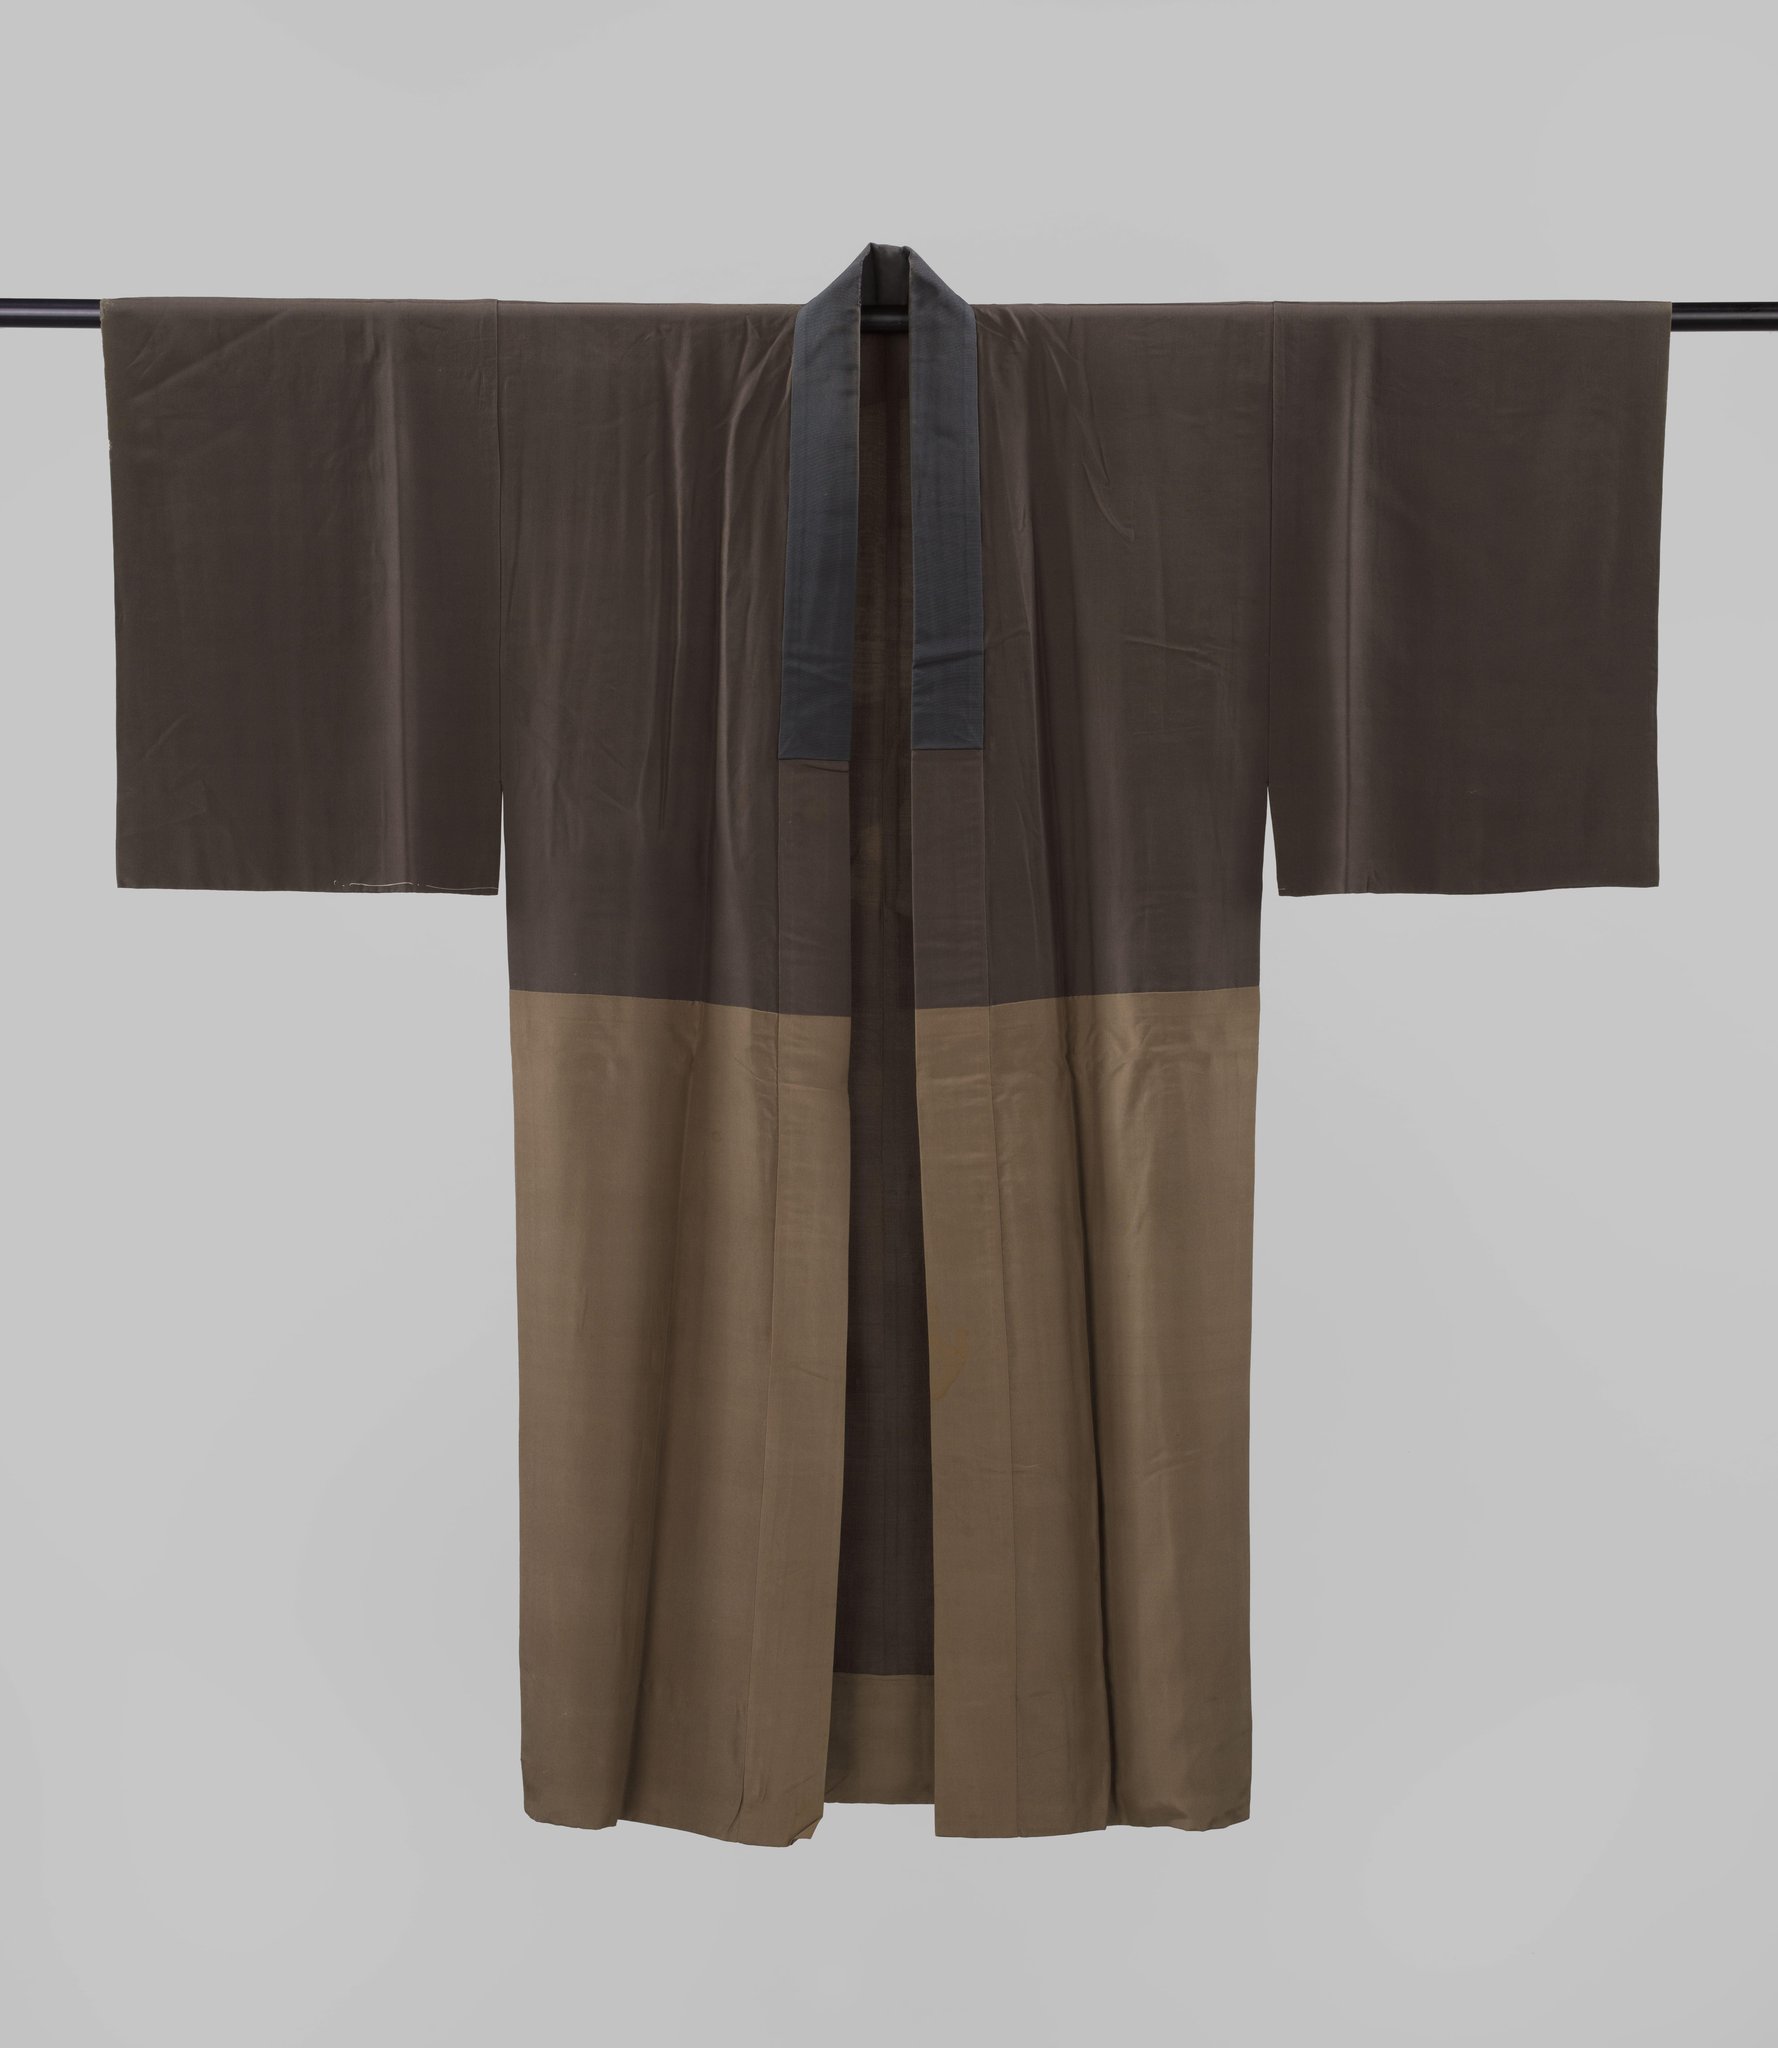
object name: kimono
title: Mannen nagajuban met muzikanten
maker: Anonymous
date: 1920-1940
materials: silk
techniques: painting, weave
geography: japan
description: Onderkimono (nagajuban) voor een man met een versiering op de bovenhelft van de achterpanden van drie muzikanten: een op een lakdoos gezeten jonge man in een kimono met esdoorn motieven en een hand trommel, een gezeten vrouw in een kimono met bananenblad motieven en jonge man in een kimono met accolade vormige vierkanten, beide met een driesnarige luit (shamisen). Op de grond een blad met rookgerei en een kamerscherm met een landschap op de achtergrond. Waarschijnlijk een verwijzing naar een huis van vermaak, waar de gast (met rookgerei) vermaakt wordt met muziek. Nostalgie: kleding en haarstijl grijpen terug op mid-17de eeuwse mode. Bruine zijde met gestencilde yuzen versiering. Voering van bruine zijde.